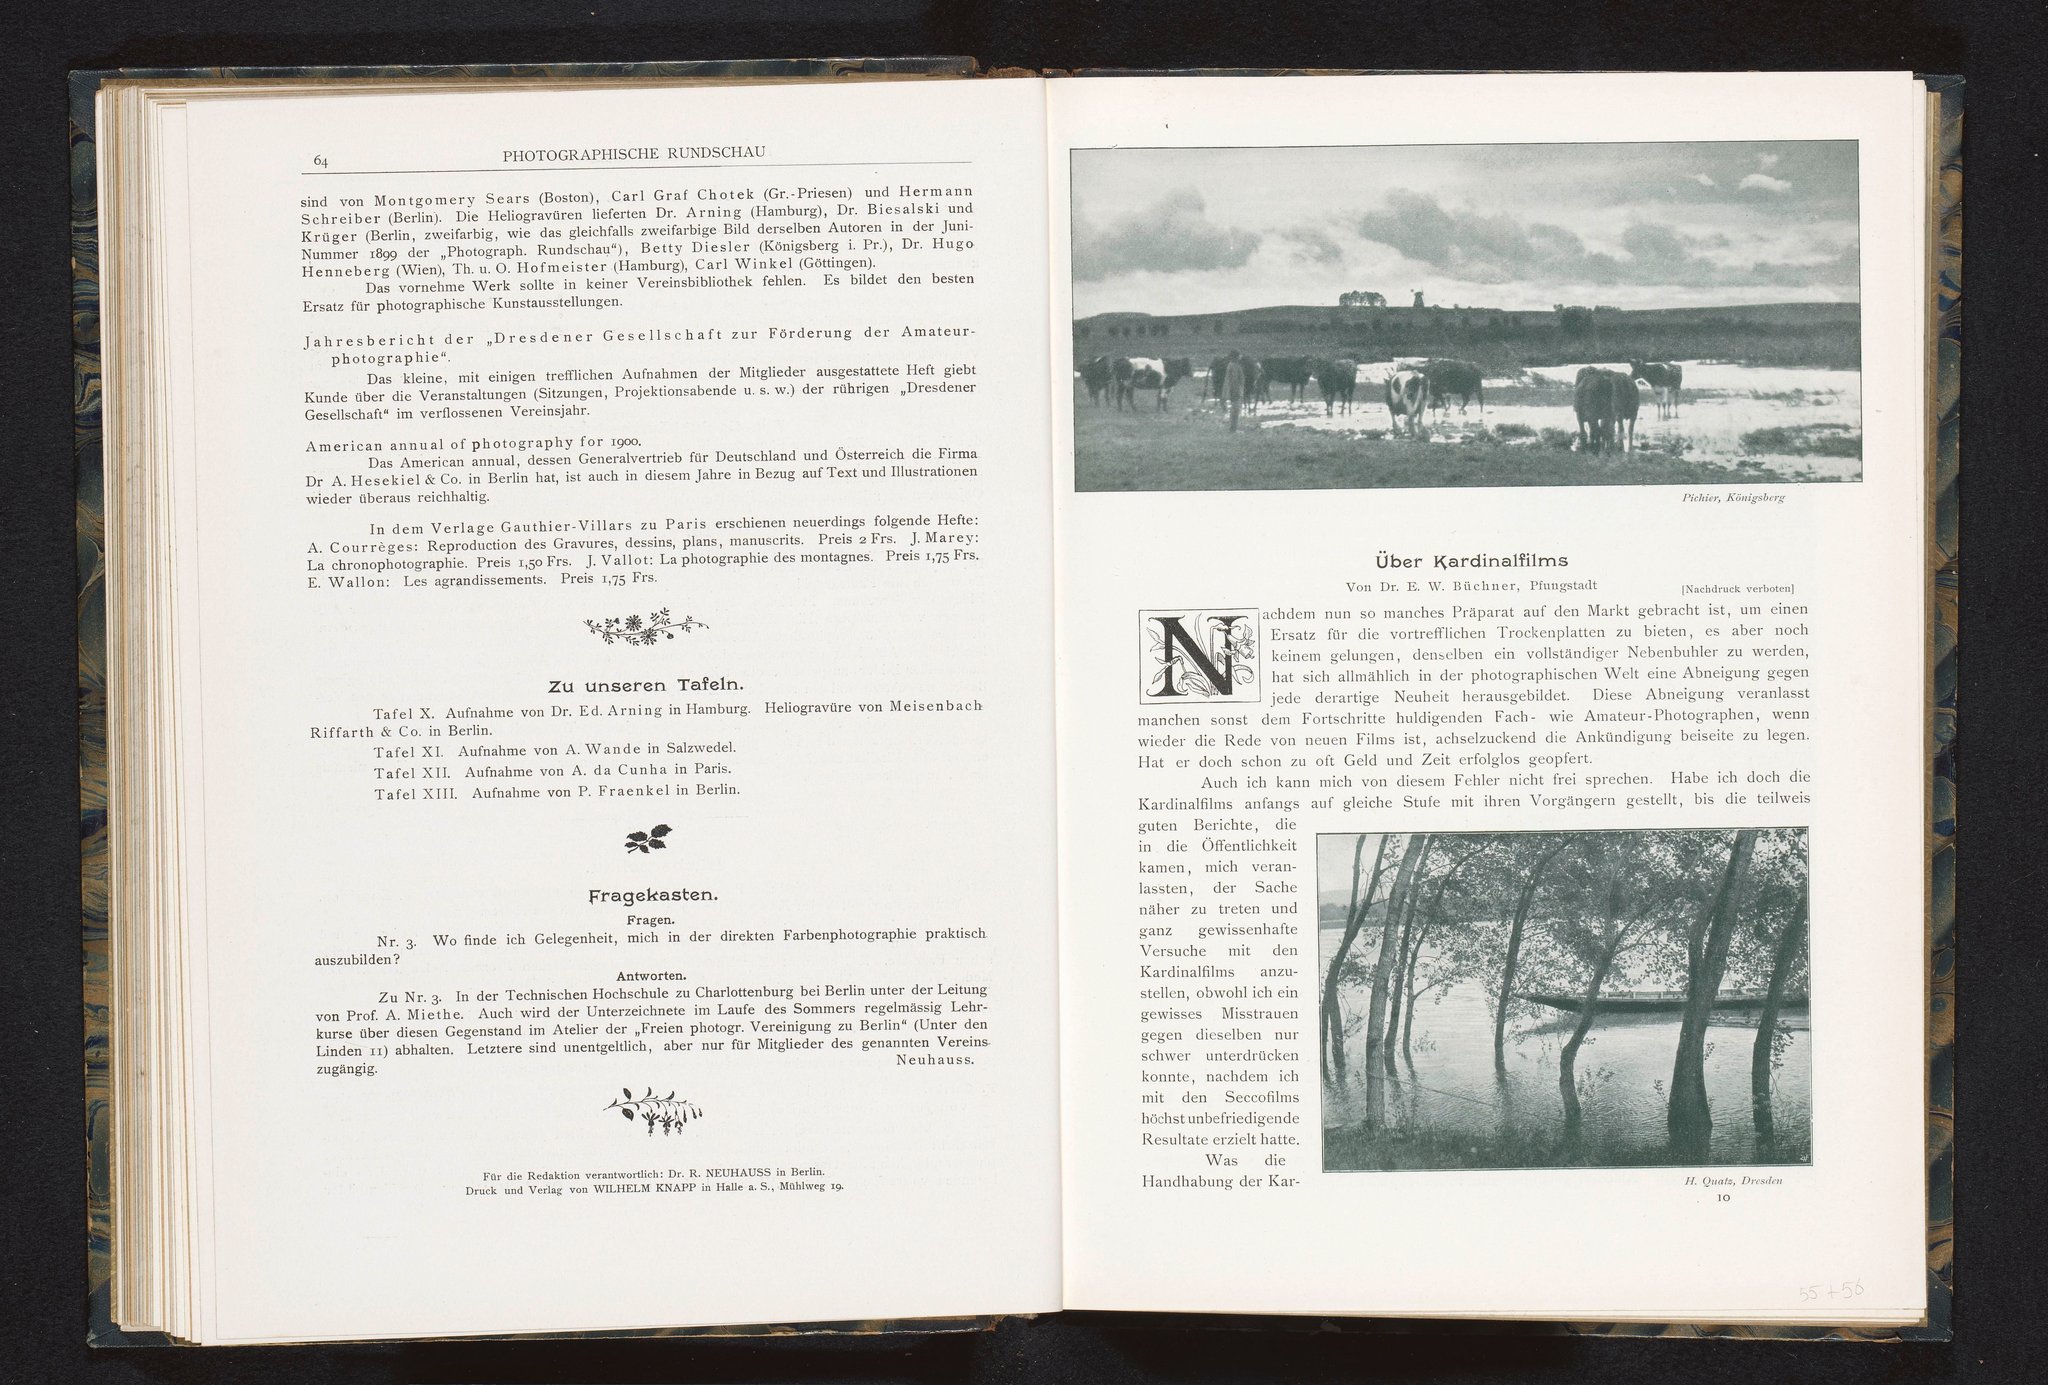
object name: photomechanical print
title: Gezicht op een kudde grazende koeien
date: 1895-1900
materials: paper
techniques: autotype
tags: cow, meadow, pasture, herd, flock